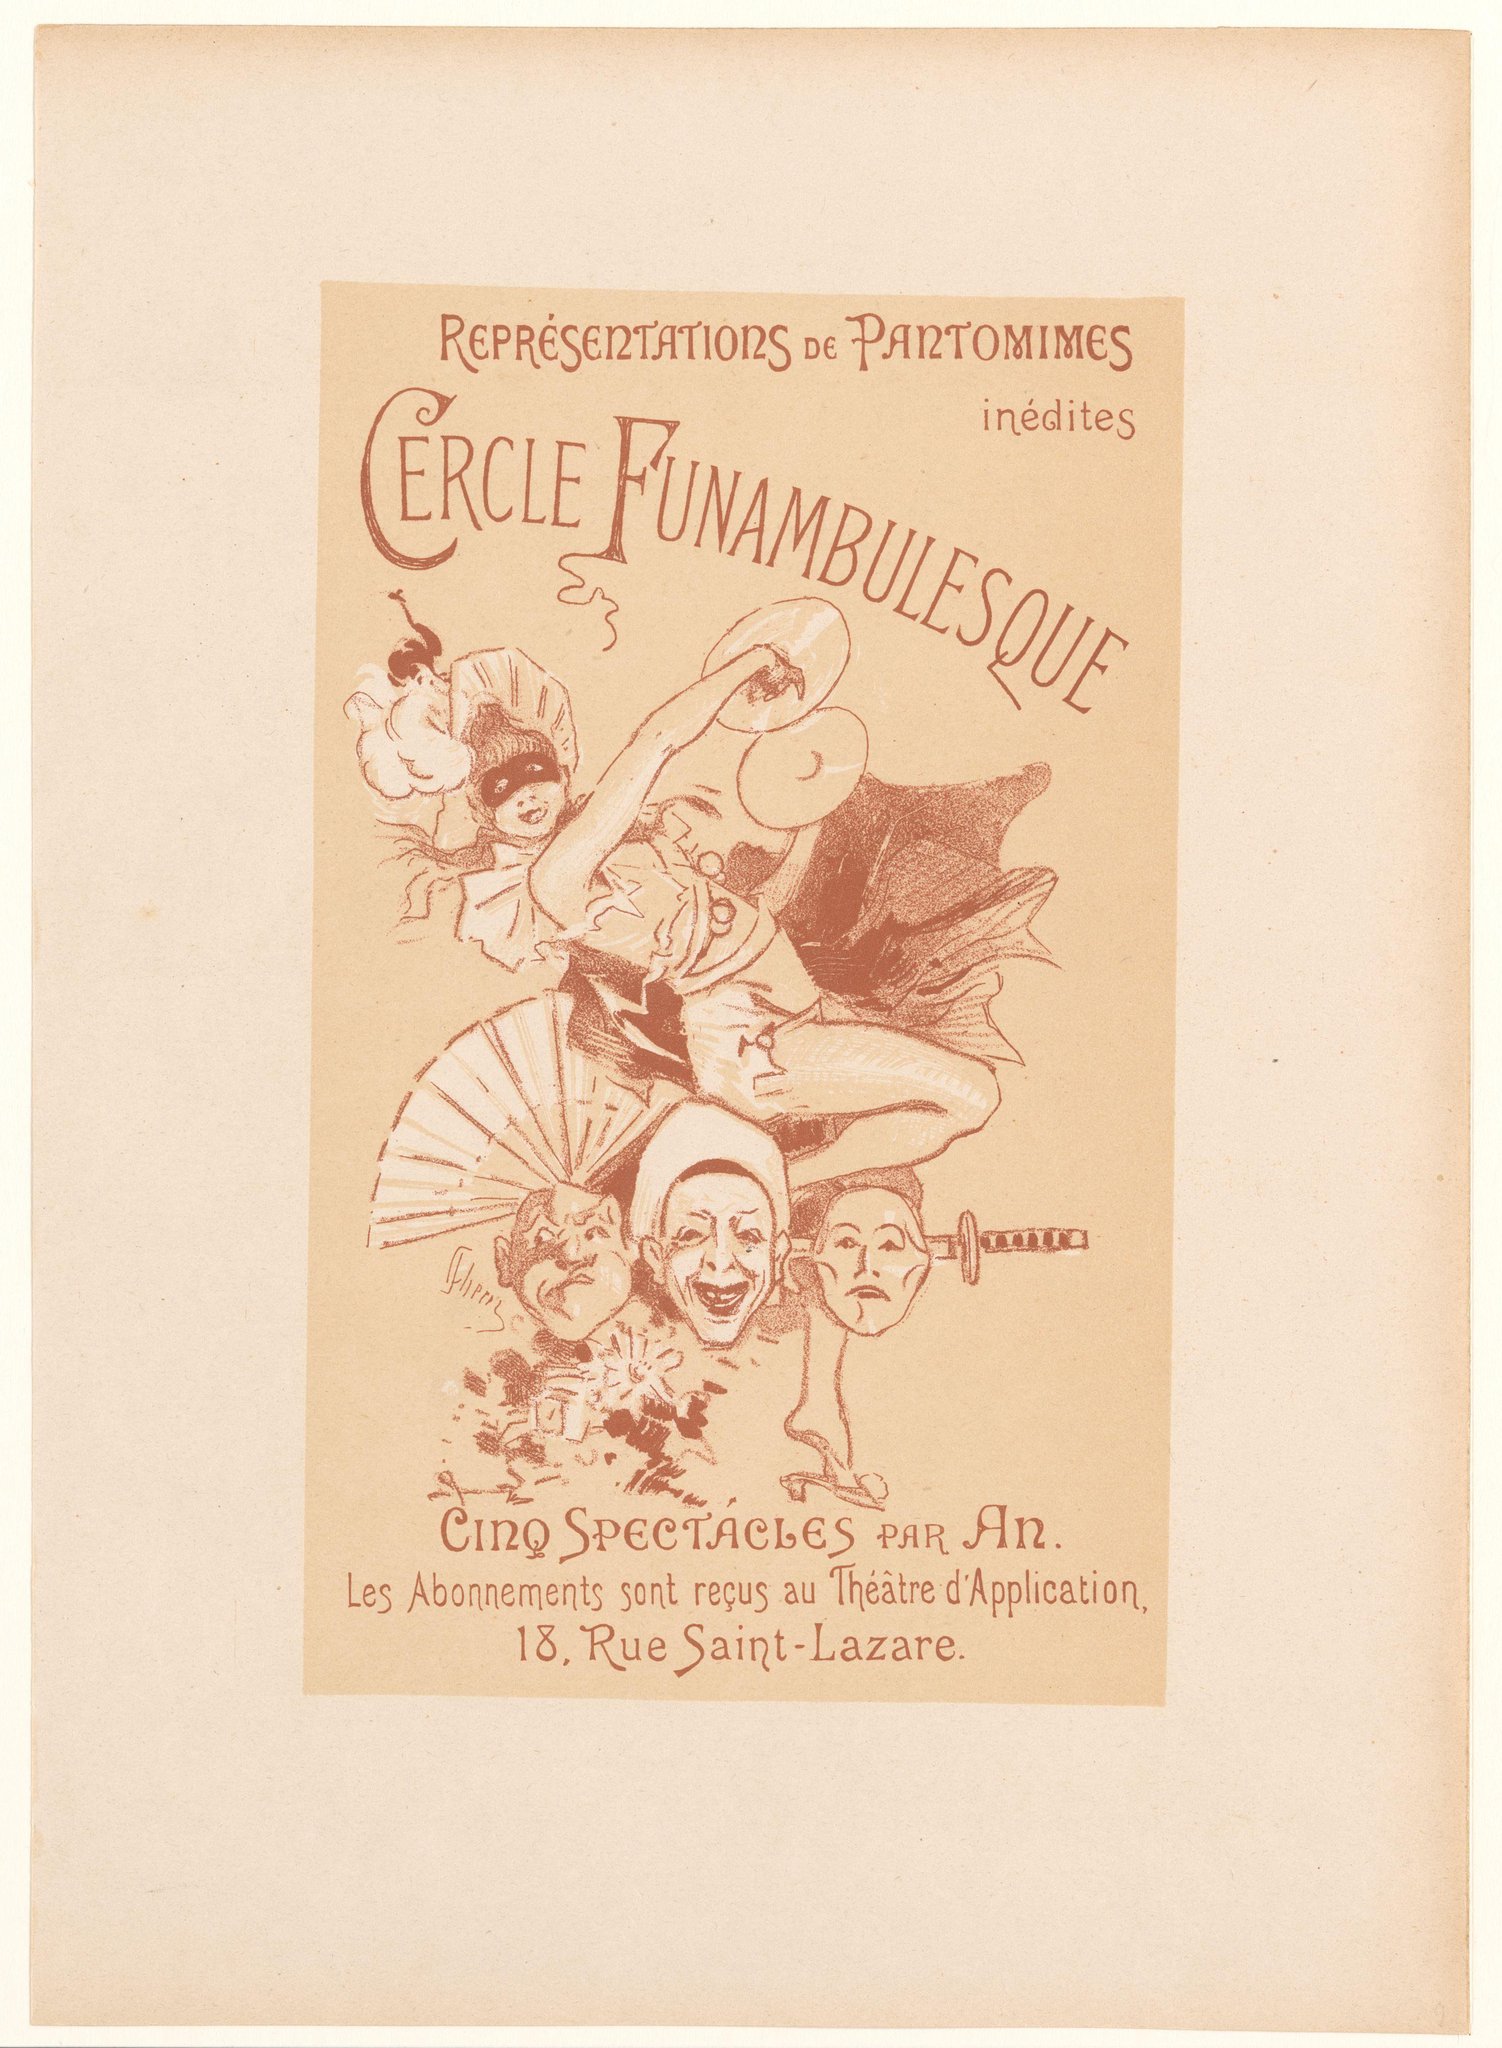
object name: print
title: Reclamekaart voor het Cercle Funambulesque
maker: jules chéret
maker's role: painter, print maker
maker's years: 1836-1932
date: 1888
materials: paper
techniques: tone lithography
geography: paris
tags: pantomime, dumb show, masque, poster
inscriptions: collector's mark: Lugt 2228a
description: Het Cercle Funambulesque was een Parijs theatergezelschap, dat pantomimes opvoerde die geïnspireerd waren op de Commedia dell'Arte.